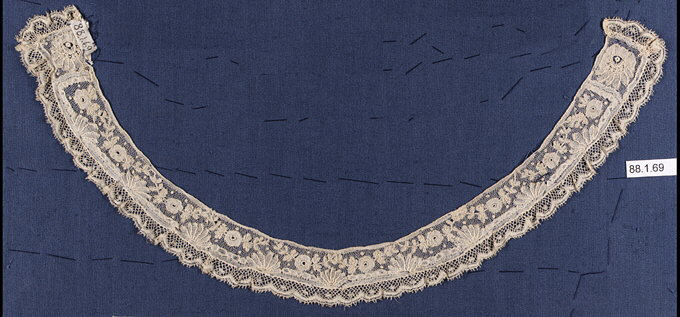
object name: collar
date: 1867-1900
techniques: lace